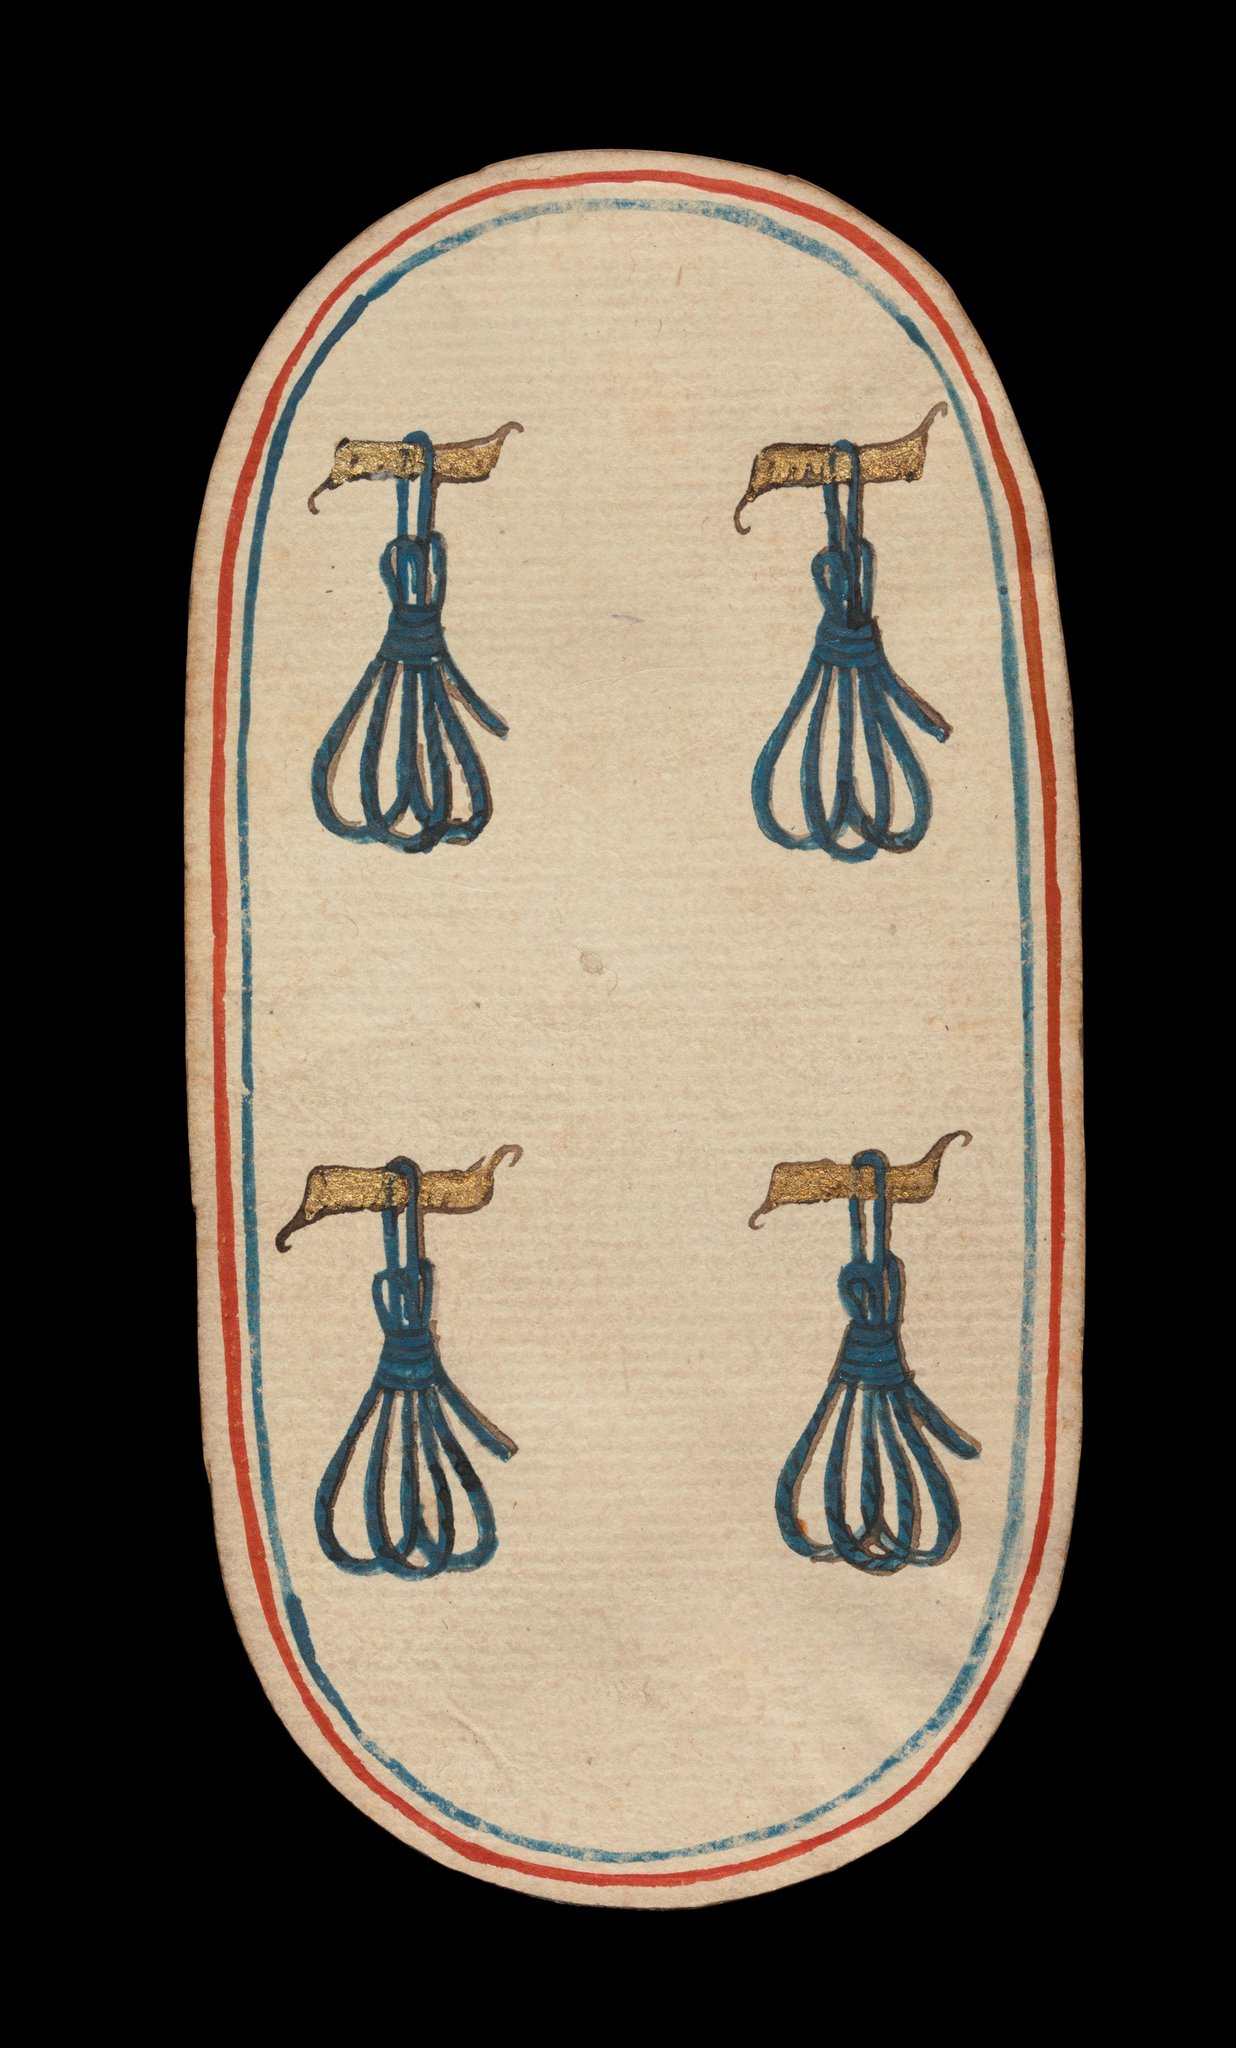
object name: playing card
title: 4 of Tethers, from The Cloisters Playing Cards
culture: south netherlandish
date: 1475-1480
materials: glaze, gold, ink, paint, paper, silver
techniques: pen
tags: playing cards,games